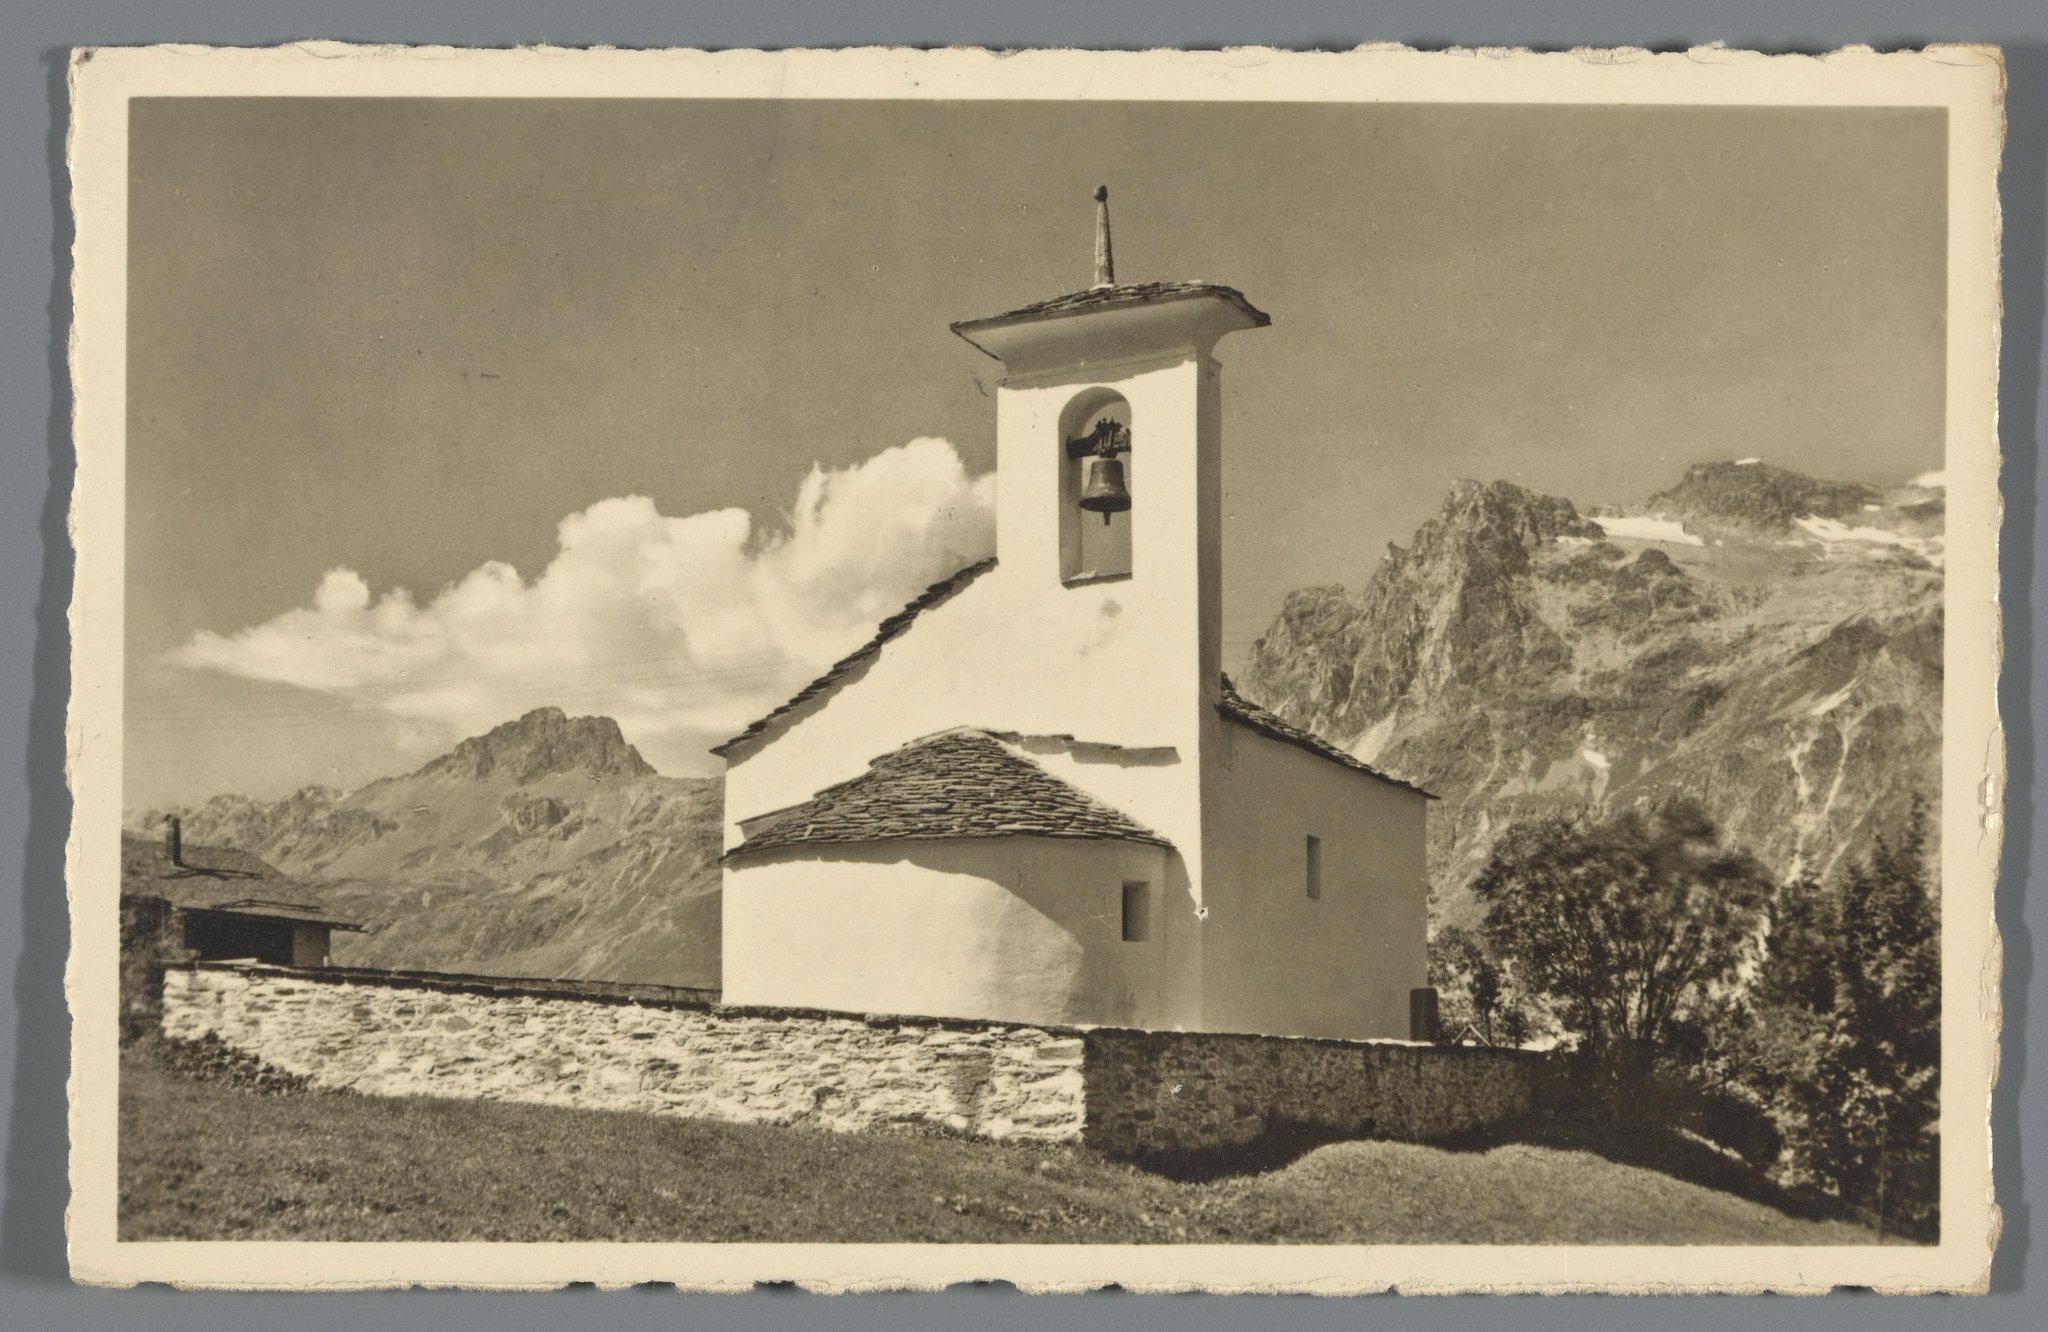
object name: photograph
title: Fextal im Ober-Engadin (1950 m), das Bergkirchlein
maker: max meerkämper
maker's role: fotograaf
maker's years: 1914-1979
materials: paper, ink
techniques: gelatin silver print, pen, writing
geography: val fex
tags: church (exterior)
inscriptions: inscription: ‘(...) Madame/ C. Osborn/ de Lauressestraat 90 III/ Amsterdam Z./ Pays-Bas.’